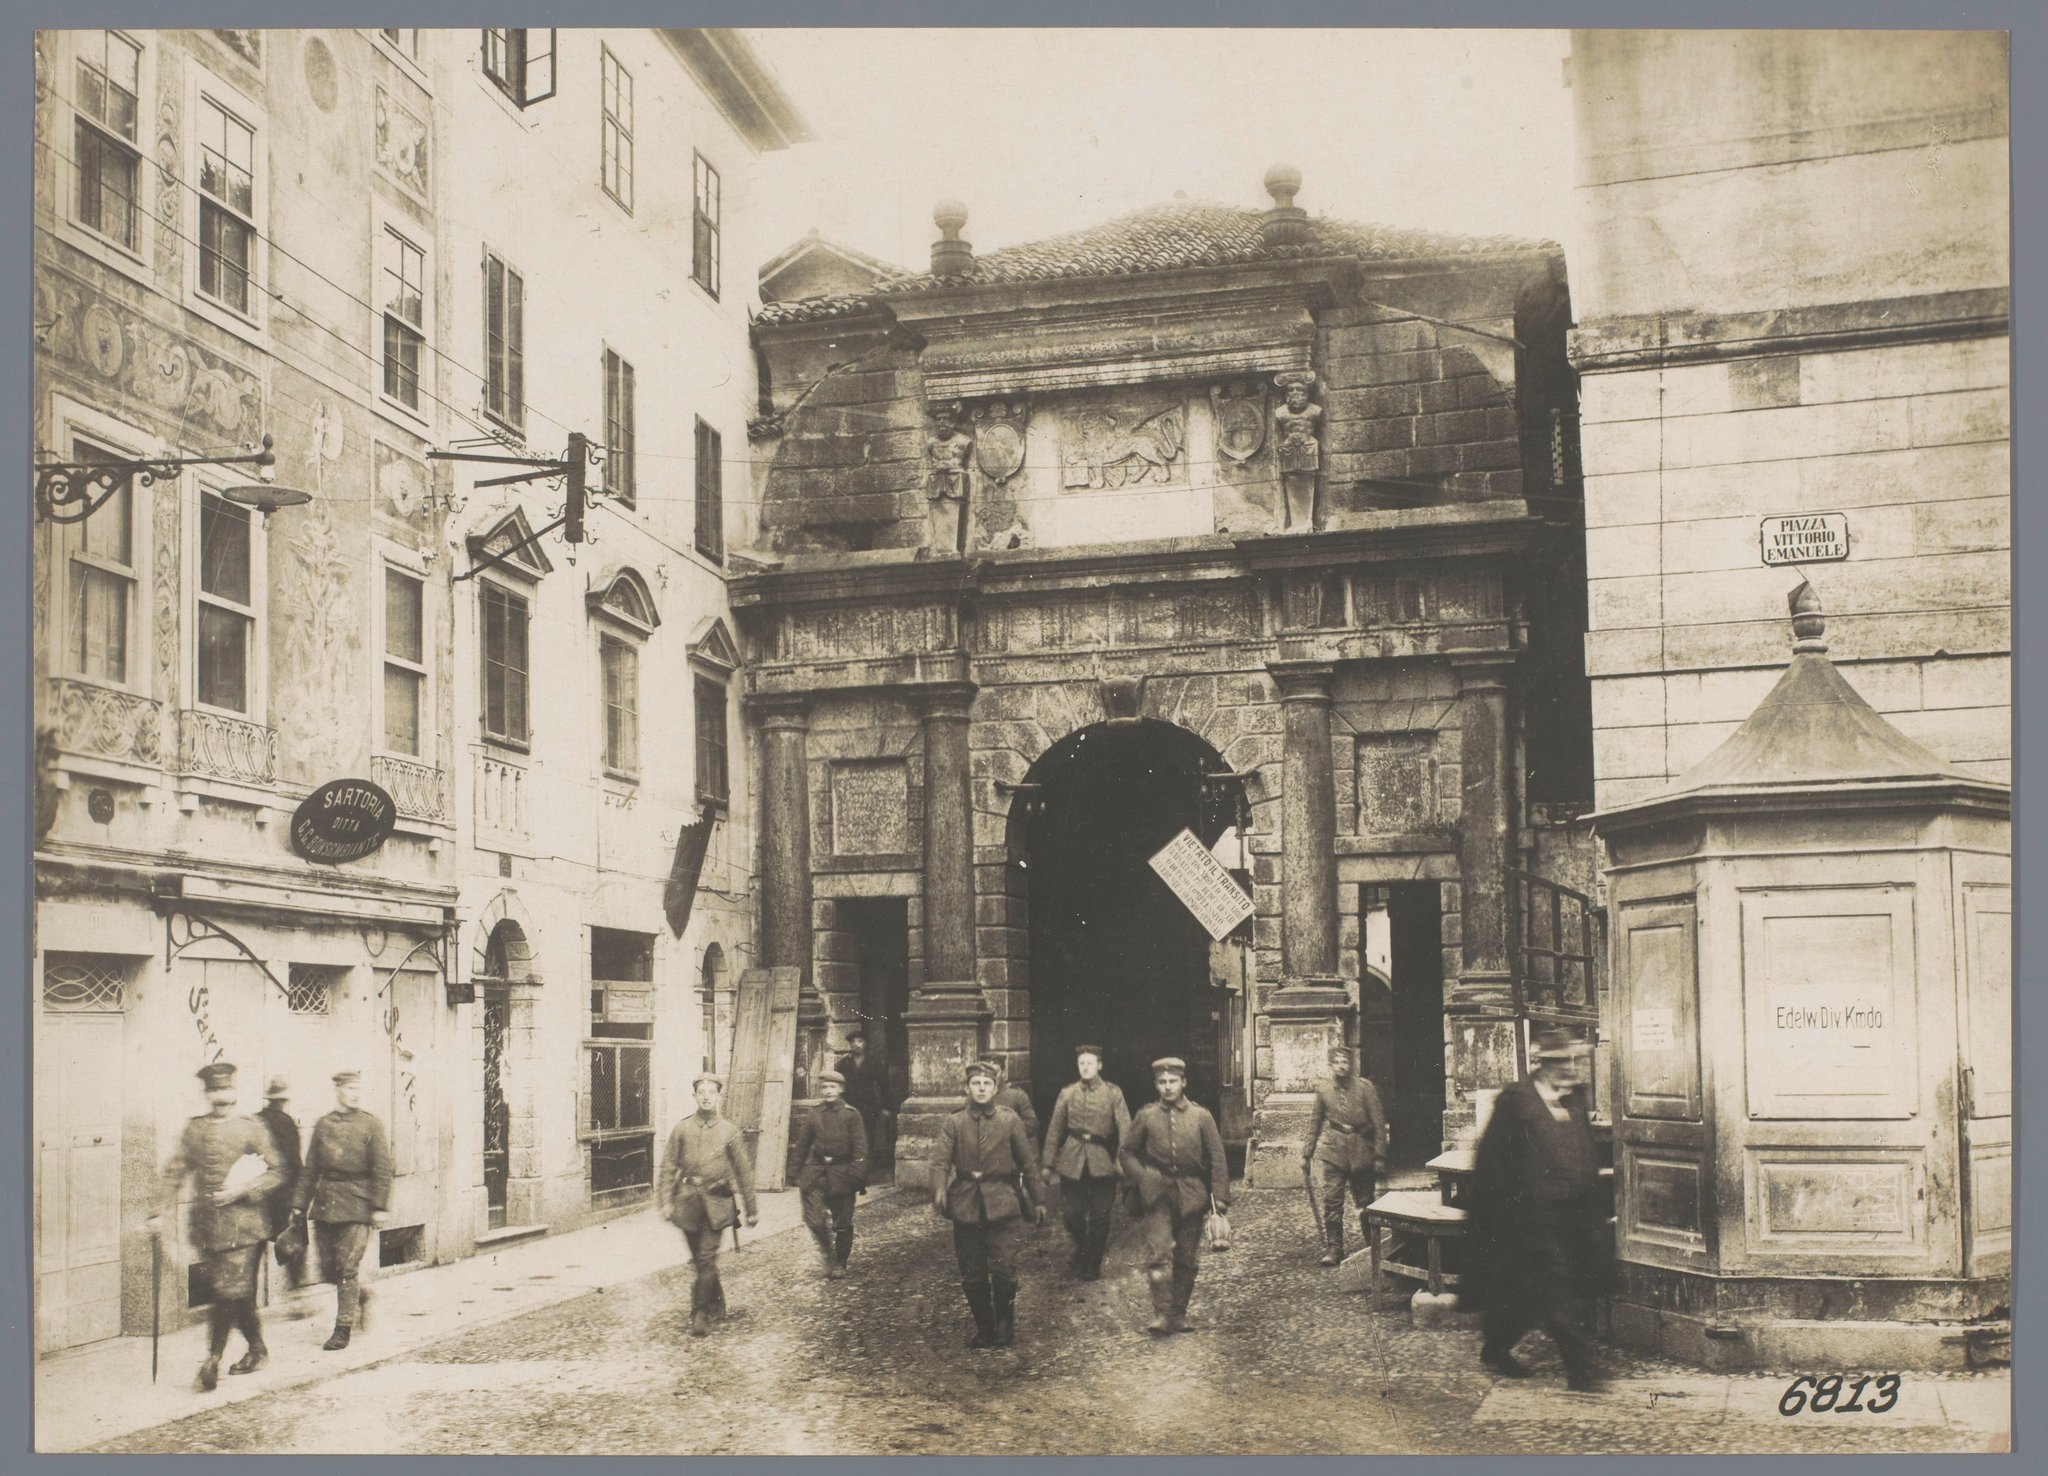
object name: photograph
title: Duitse soldaten in een Italiaanse stad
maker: Anonymous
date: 1917-1918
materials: paper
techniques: gelatin silver print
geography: italy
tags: occupier and civilians, italy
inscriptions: number: ‘6813’